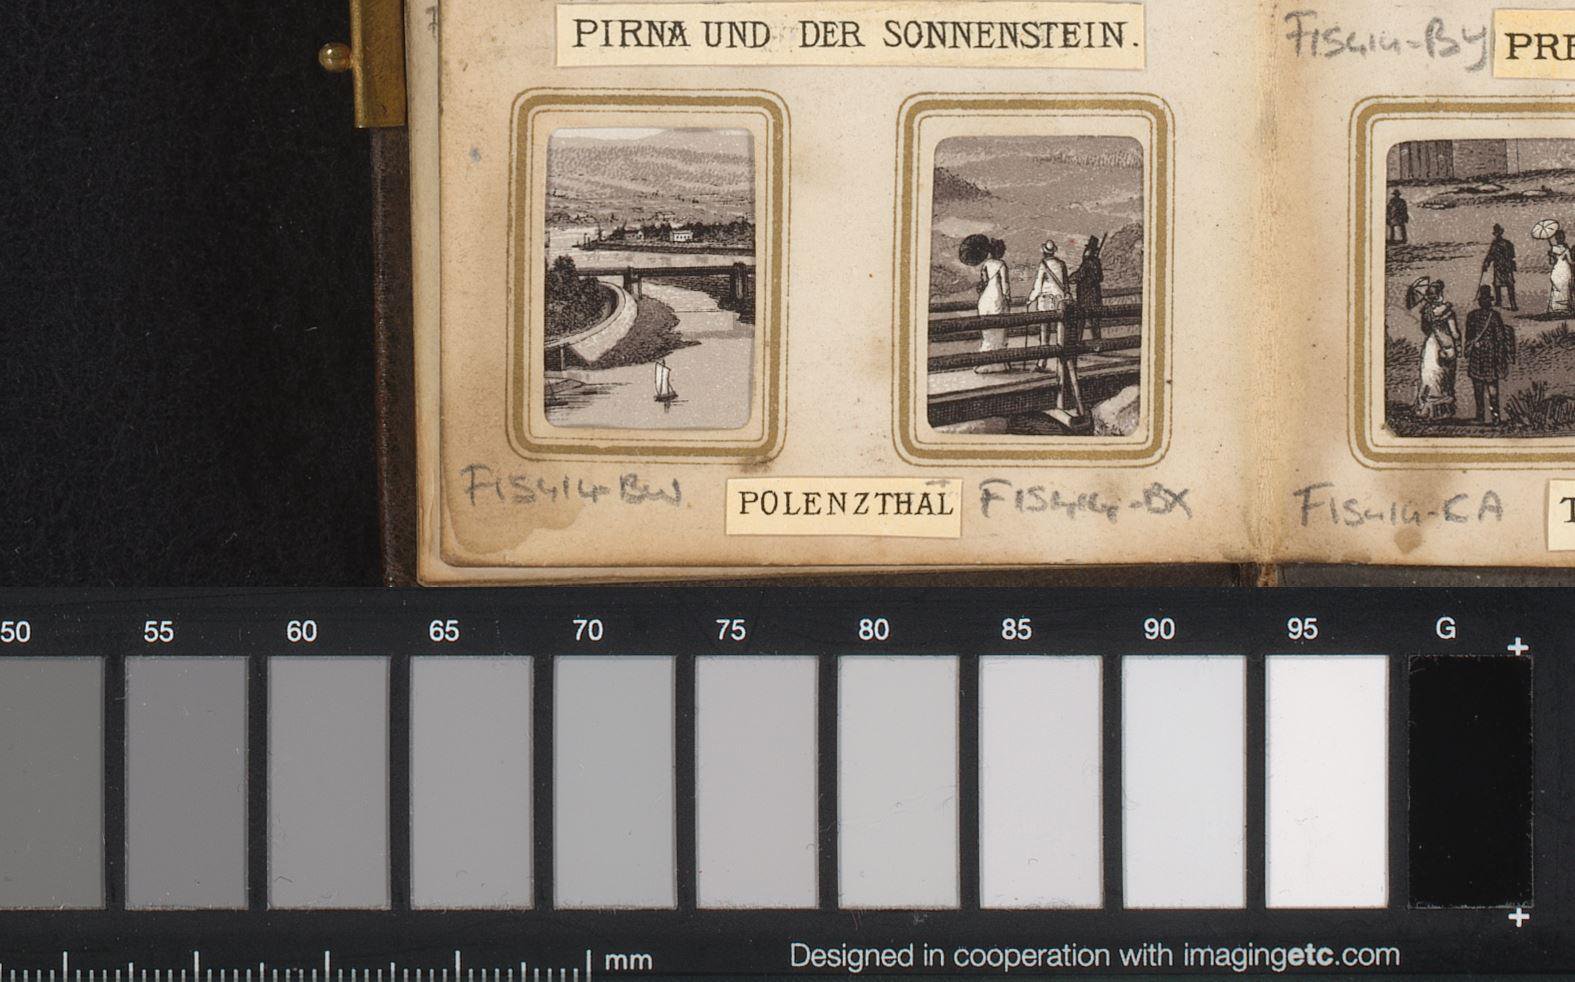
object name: print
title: Wandelaars kijken uit op het dal rondom de Polenz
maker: Anonymous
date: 1851-1910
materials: paper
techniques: lithograph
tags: walking, hiking (recreation)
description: Deze prent maakt deel uit van een album.